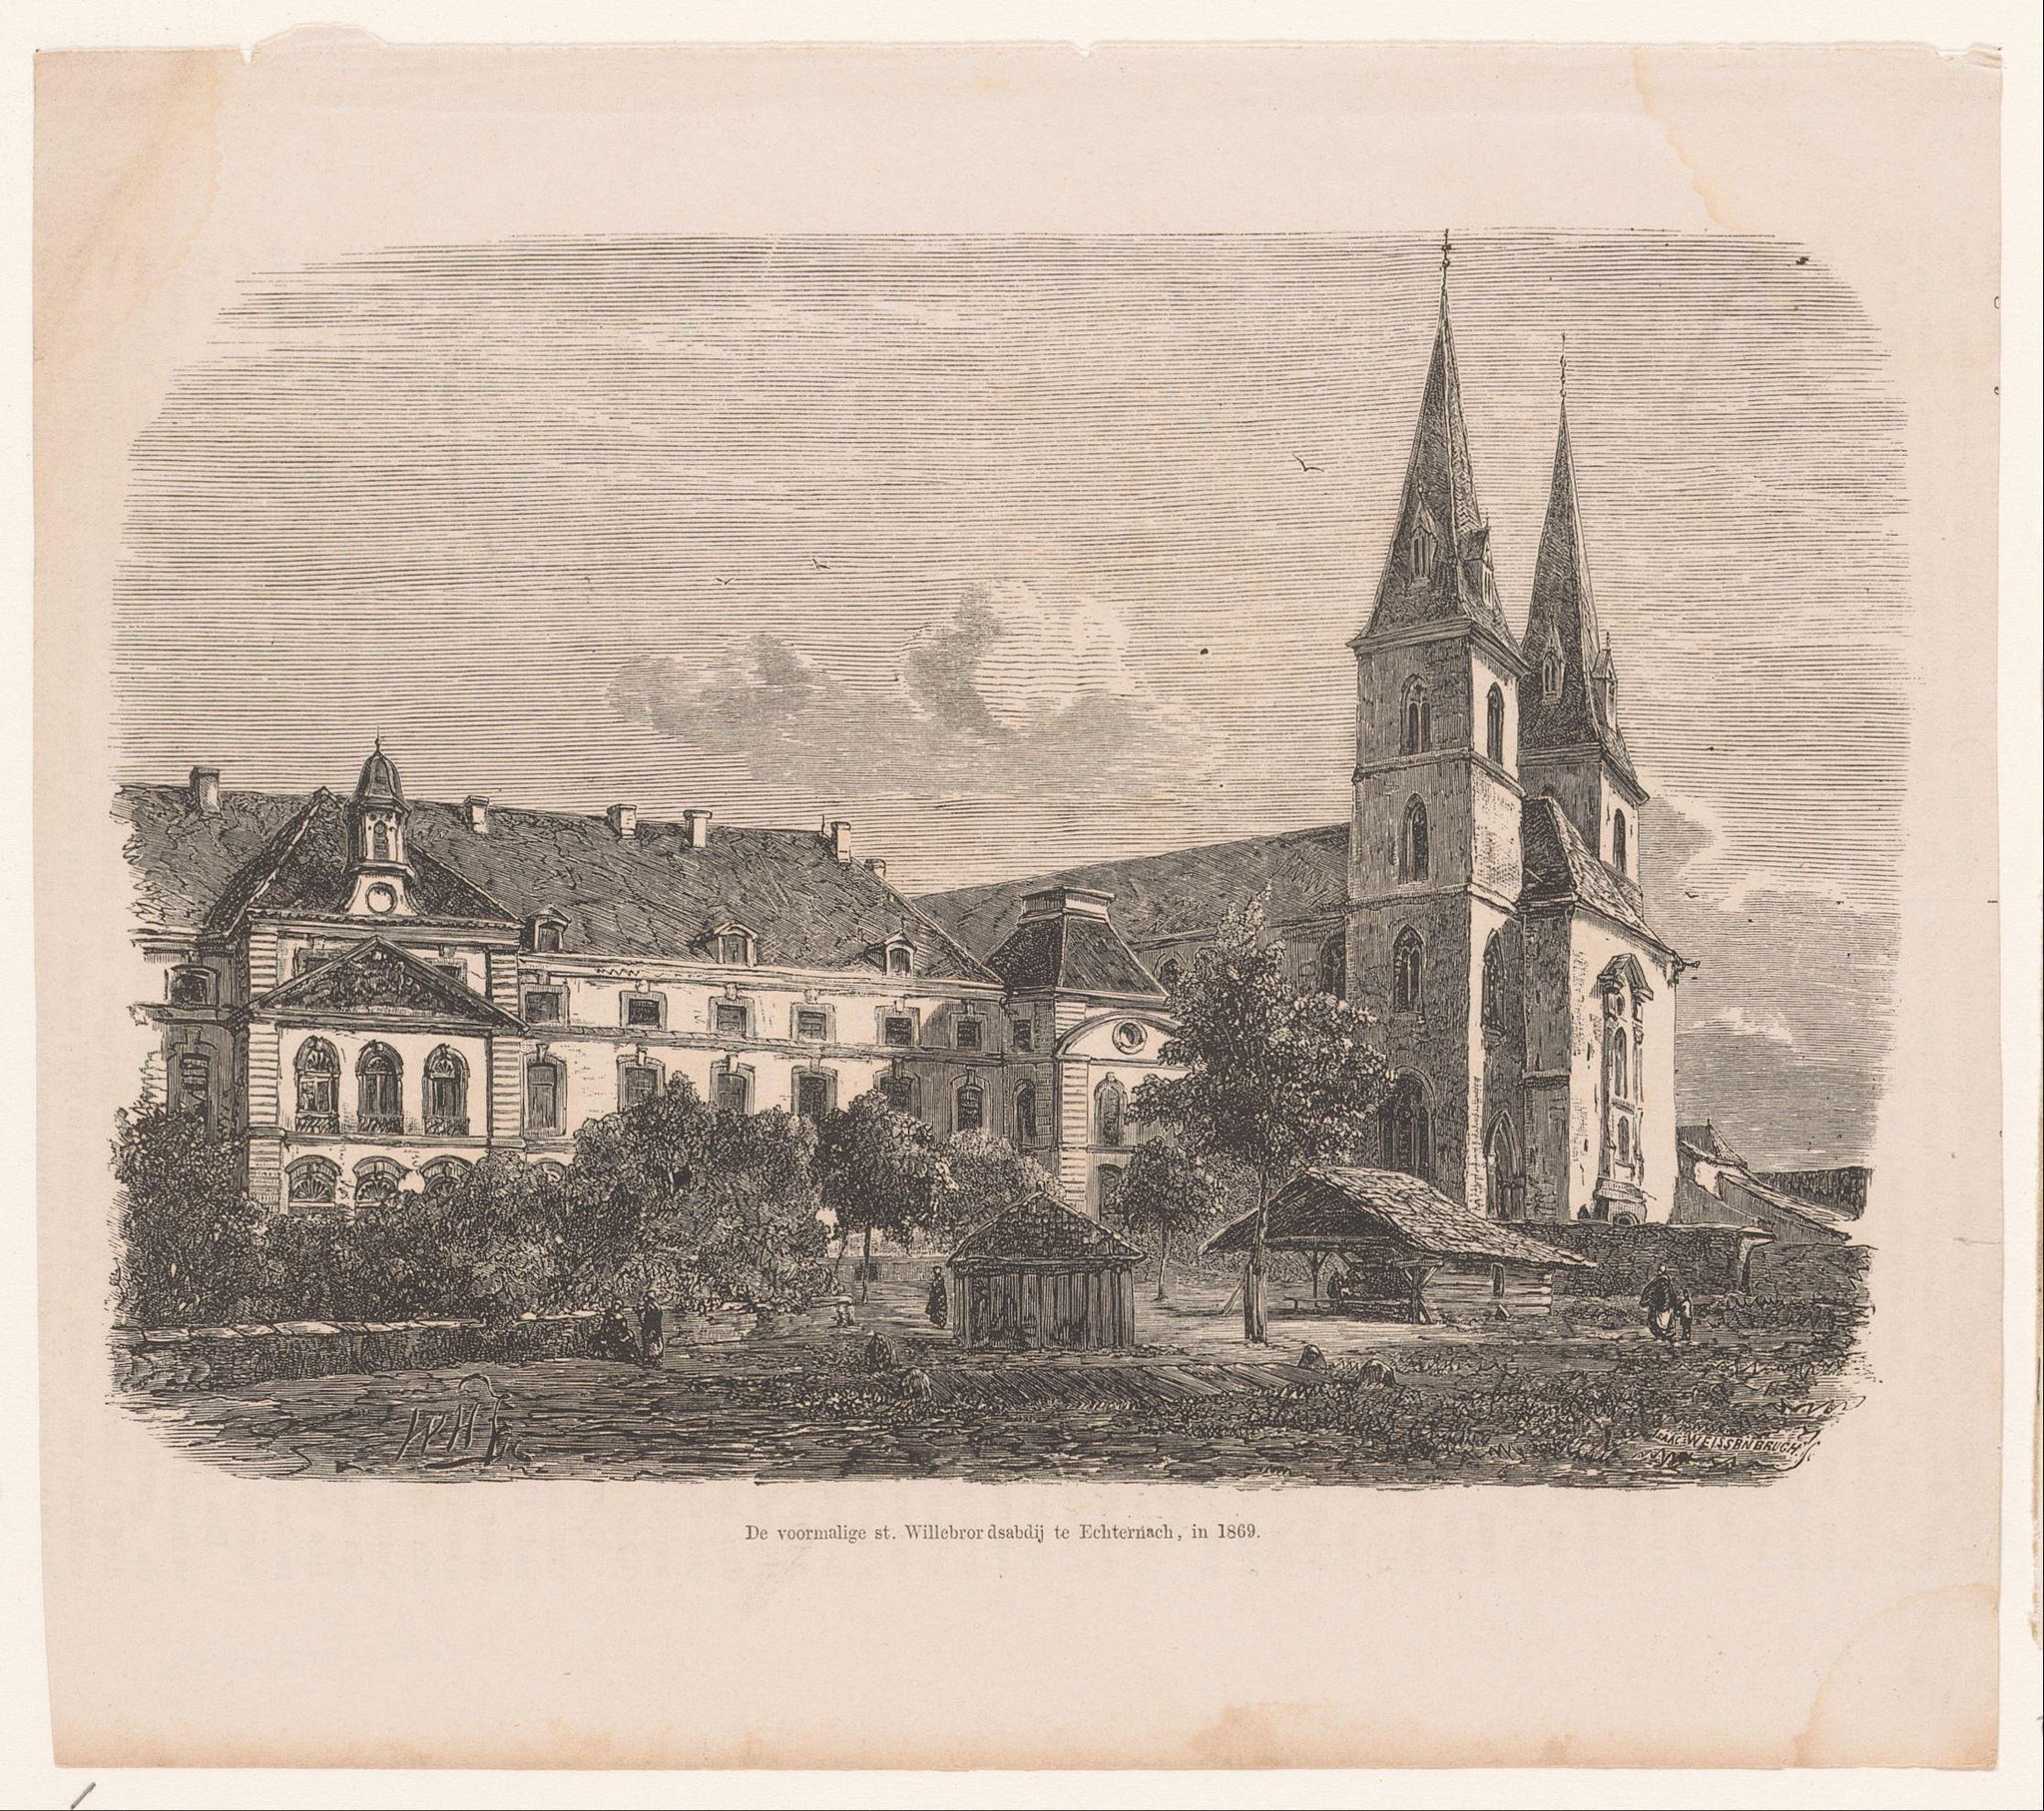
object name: book illustration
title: Gezicht op de voormalige abdij van Echternach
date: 1873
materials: paper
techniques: letterpress printing, engraving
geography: amsterdam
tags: abbey, monastery, convent ~ roman catholic church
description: Prent uit: Witkamp, P.H. Geschiedenis der Zeventien Nederlanden. 2 dln. Amsterdam: L. van Bakkenes & Co., 1873, dl. 1, p. 117.